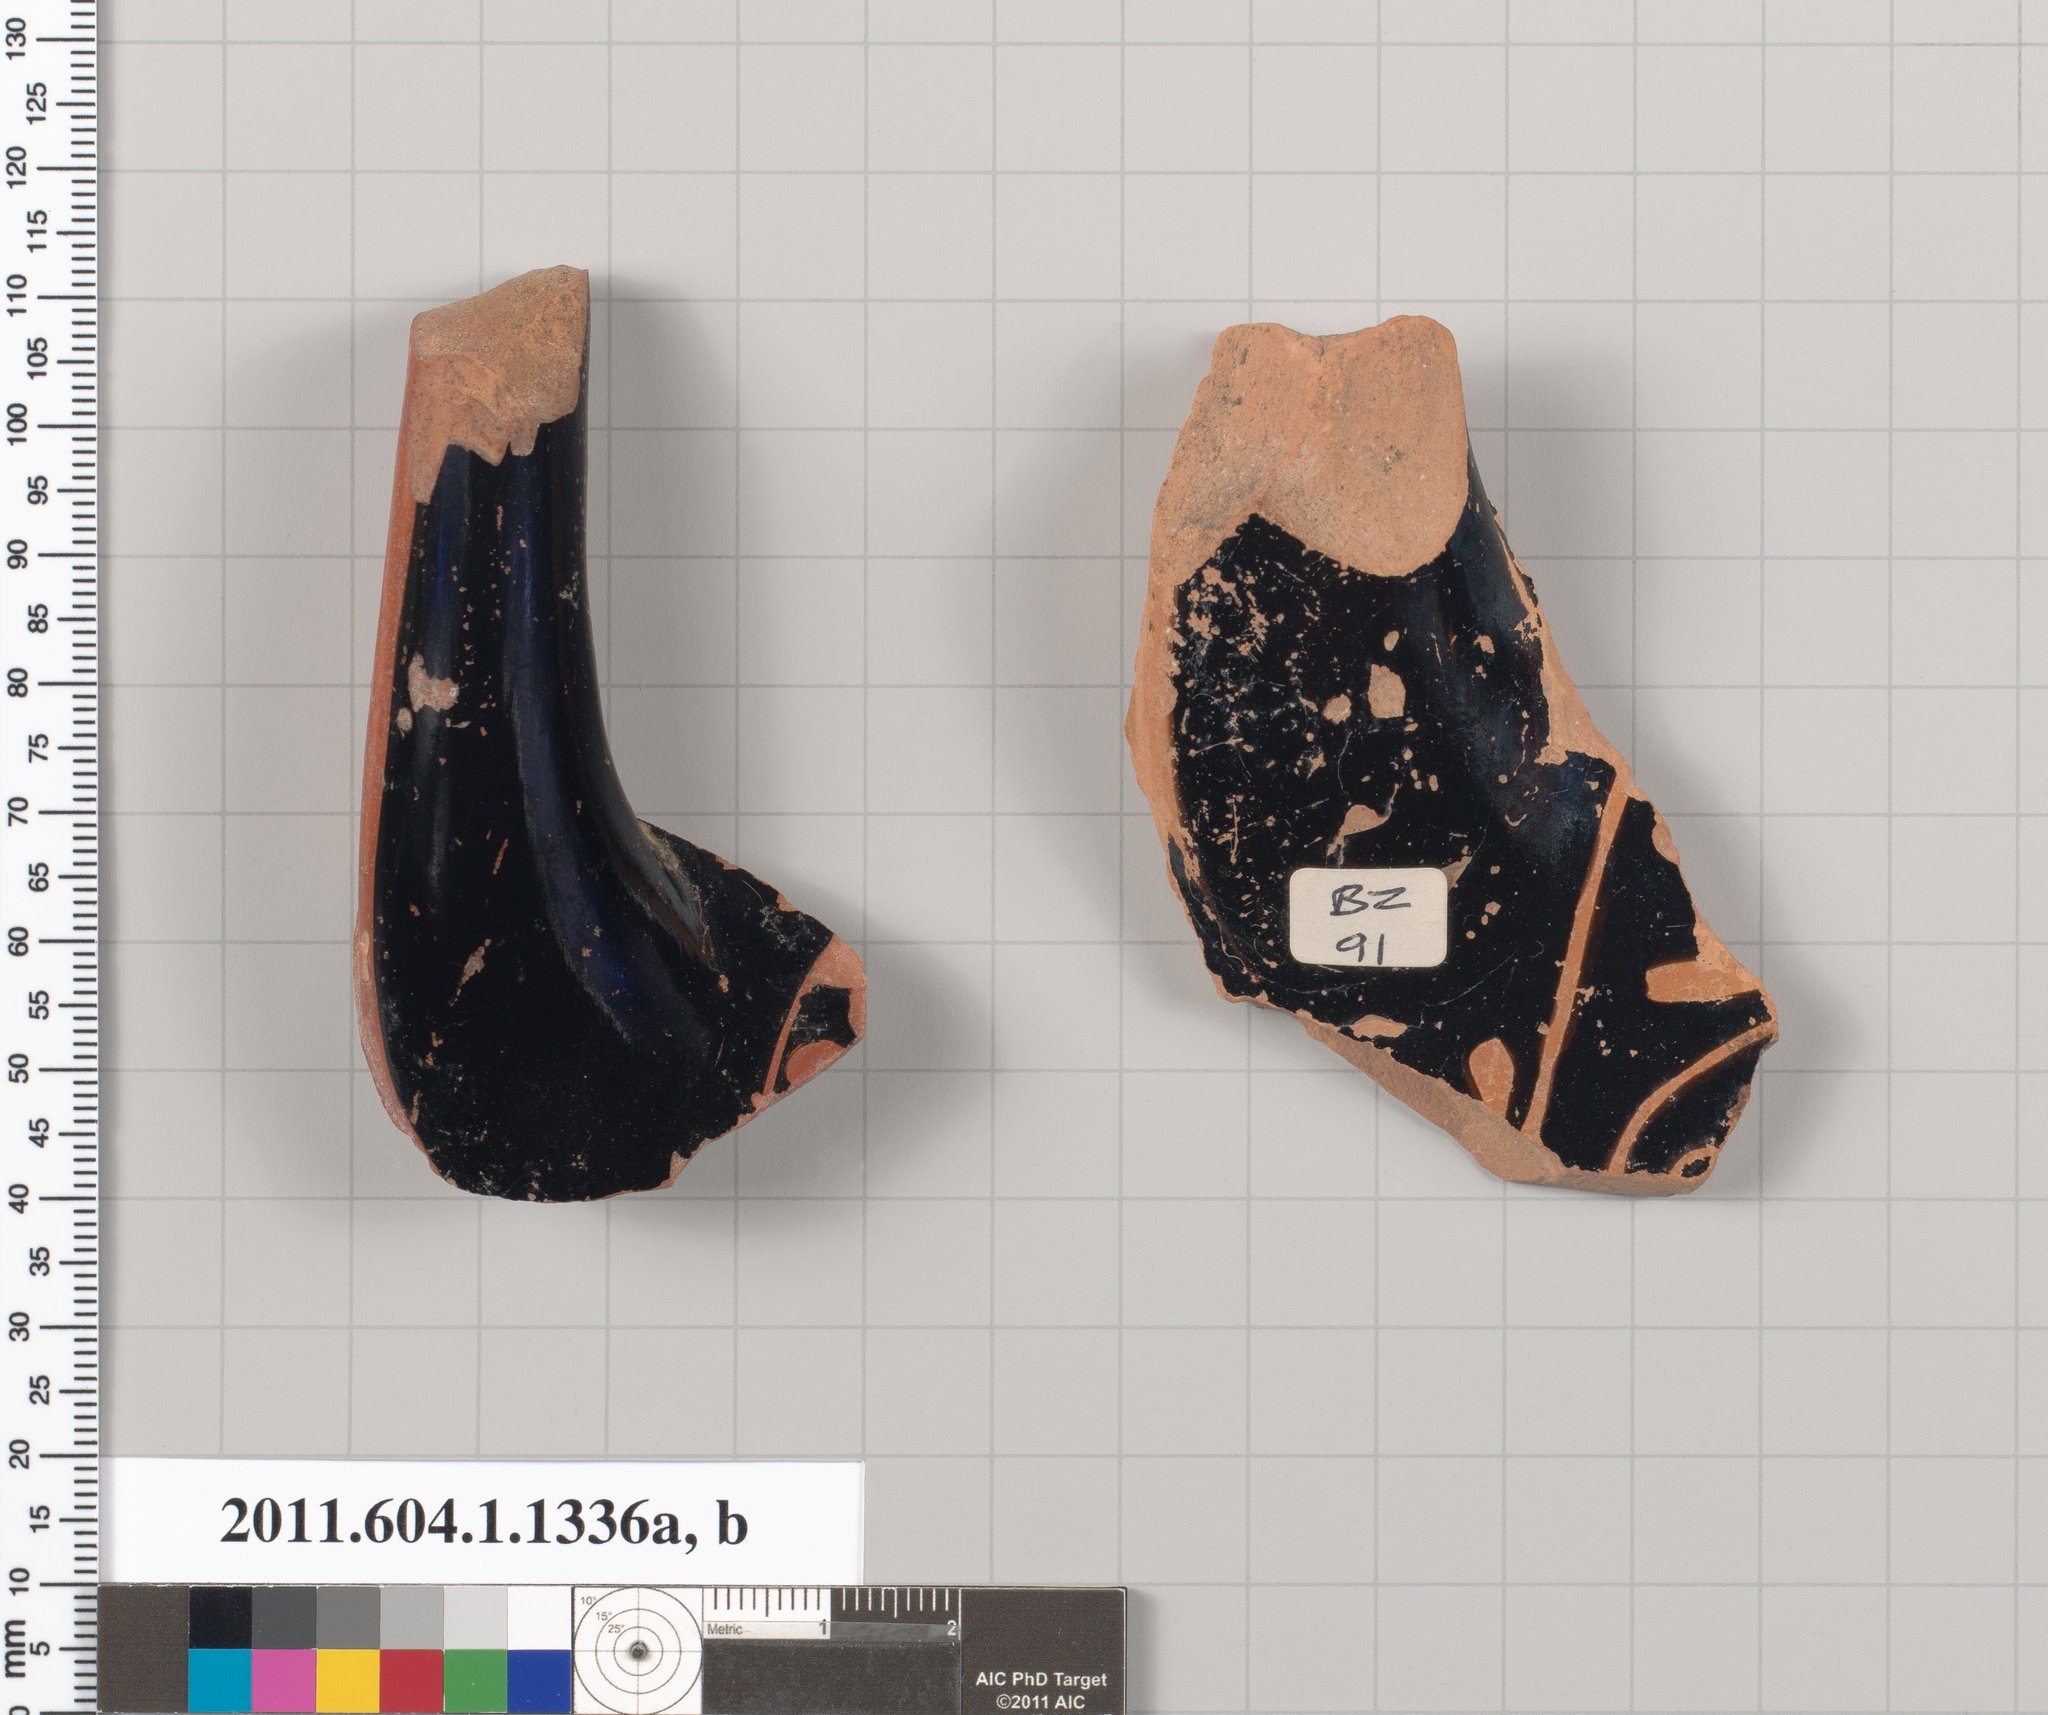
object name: kylix fragment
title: Terracotta fragments of kylikes (drinking cups)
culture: greek, attic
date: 500-401 BCE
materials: terracotta